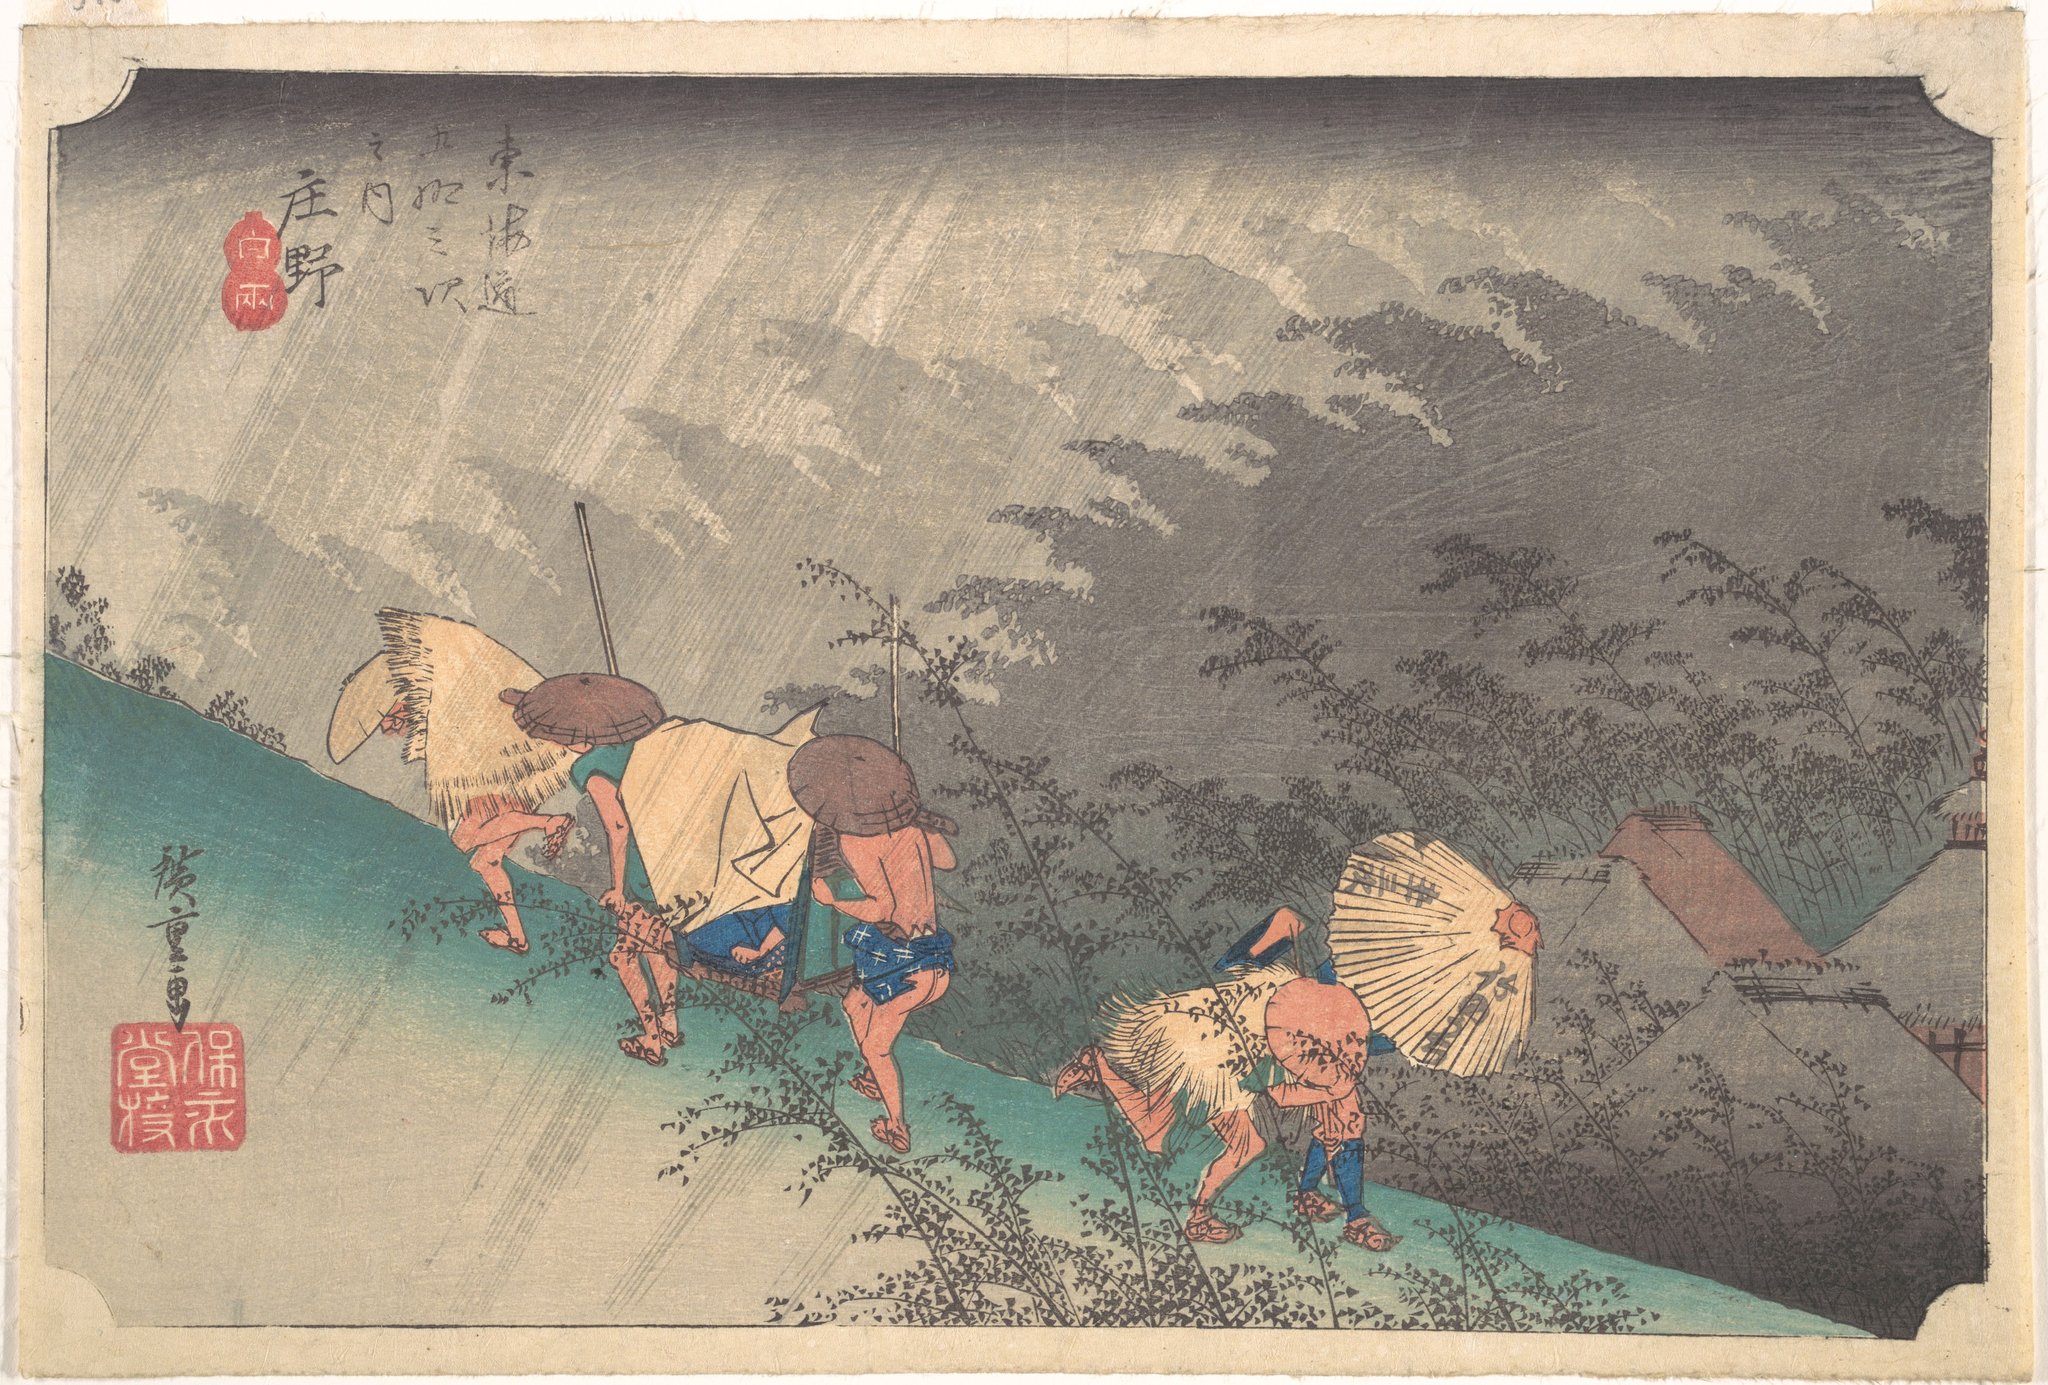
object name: print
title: Sudden Shower in Shōno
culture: japanese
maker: utagawa hiroshige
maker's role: artist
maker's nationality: japanese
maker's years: 1797-1858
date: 1833-1834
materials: ink, paper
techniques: woodblock print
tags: men,rain